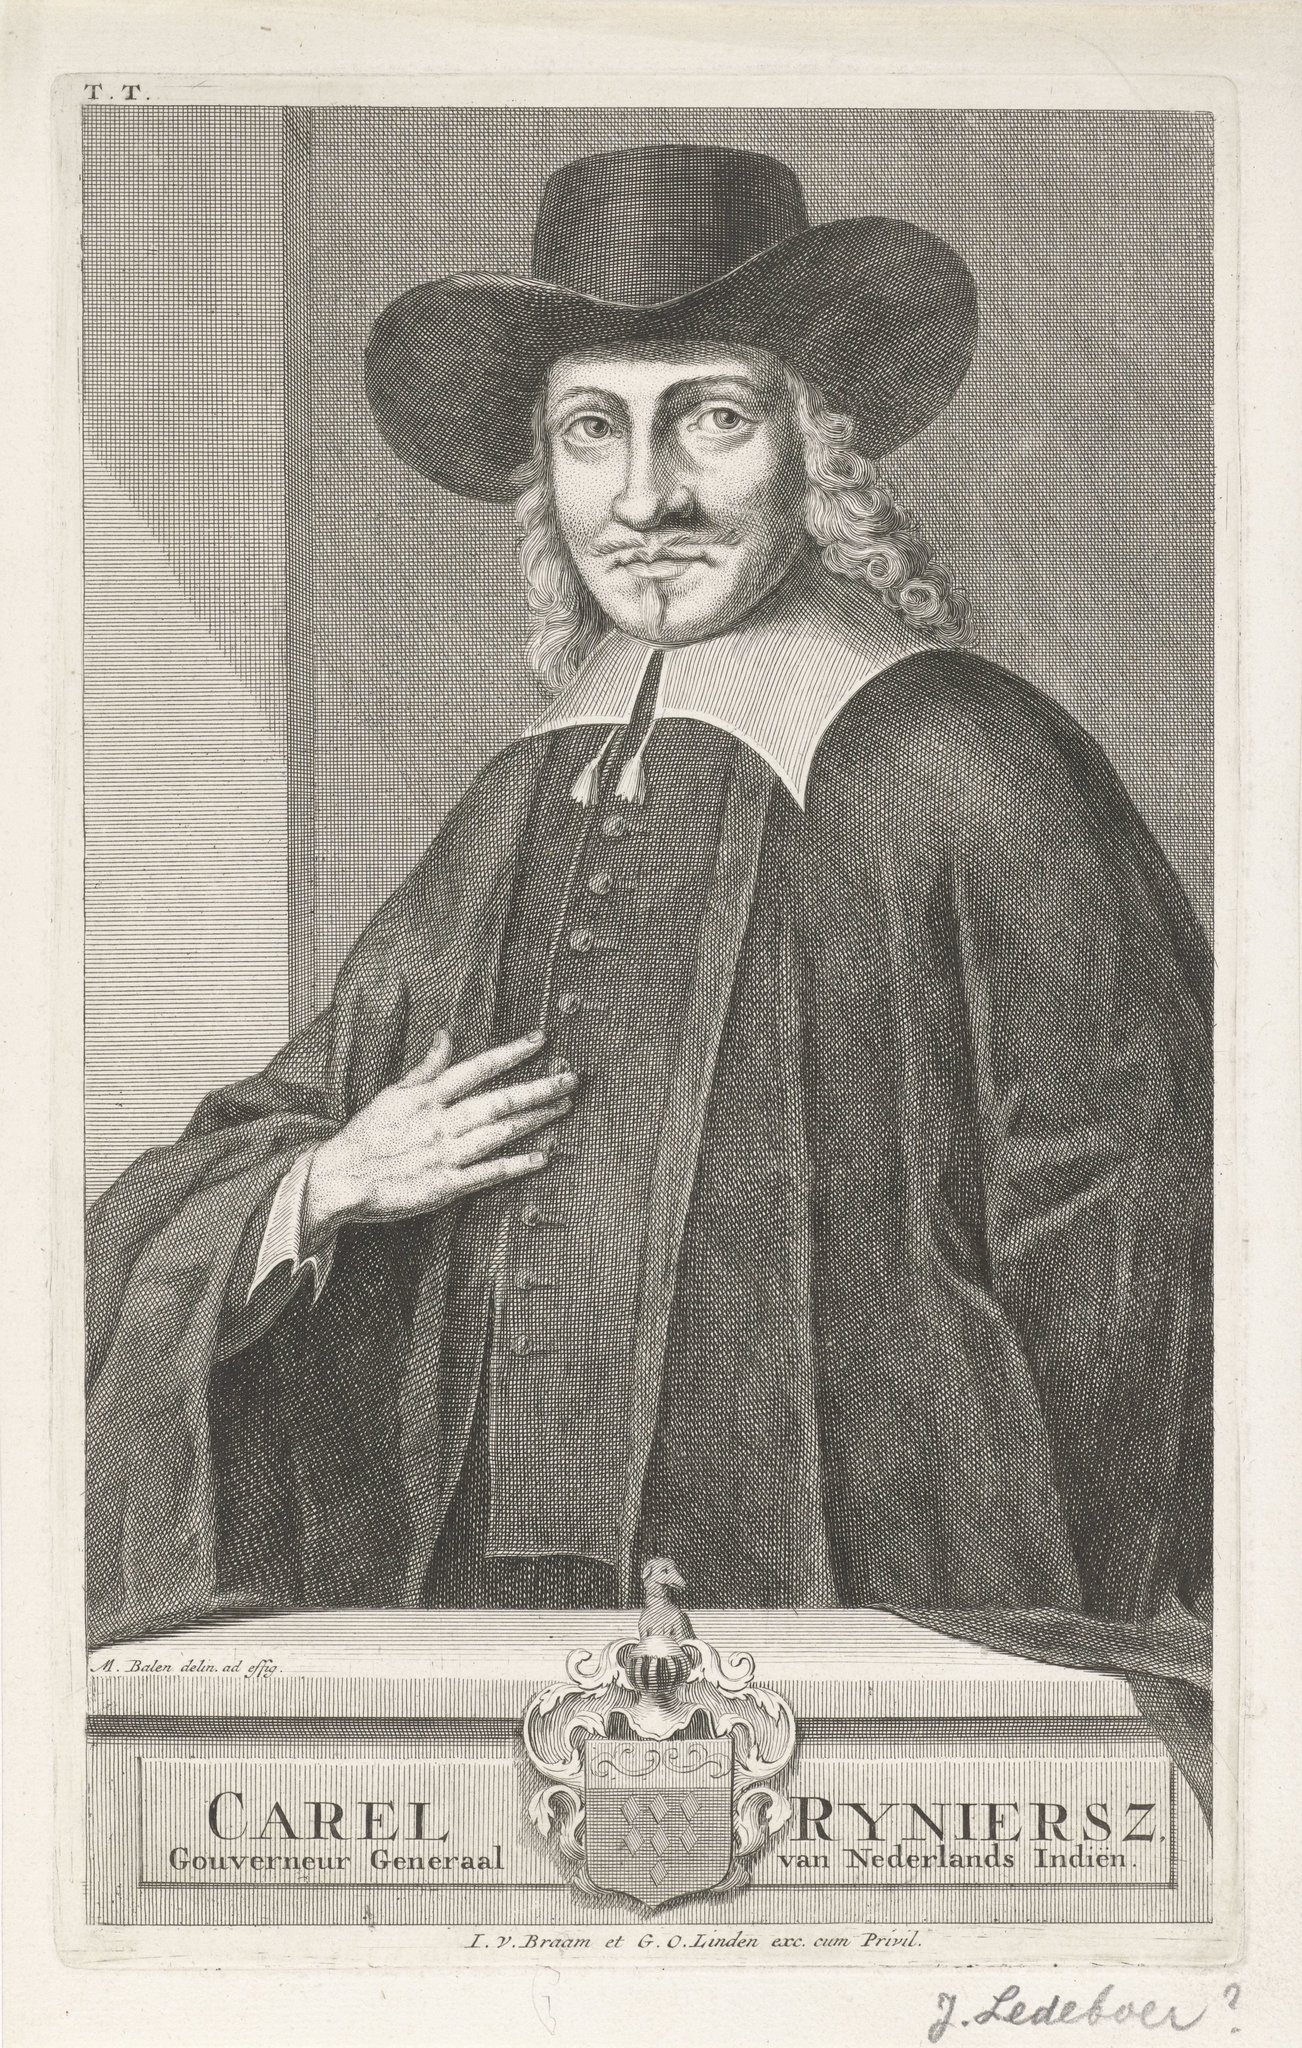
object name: print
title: Portret van Carel Reyniersz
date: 1702-1749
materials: paper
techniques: engraving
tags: batavia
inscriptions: collector's mark: Lugt 2228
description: Portret ten halven lijve naar links van Carel Reyniersz, gouverneur-generaal van Nederlands-Indië, met hoed. Onder het portret staan de naam, titel en het wapenschild van de geportretteerde. Prent linksboven gemerkt: T.T.